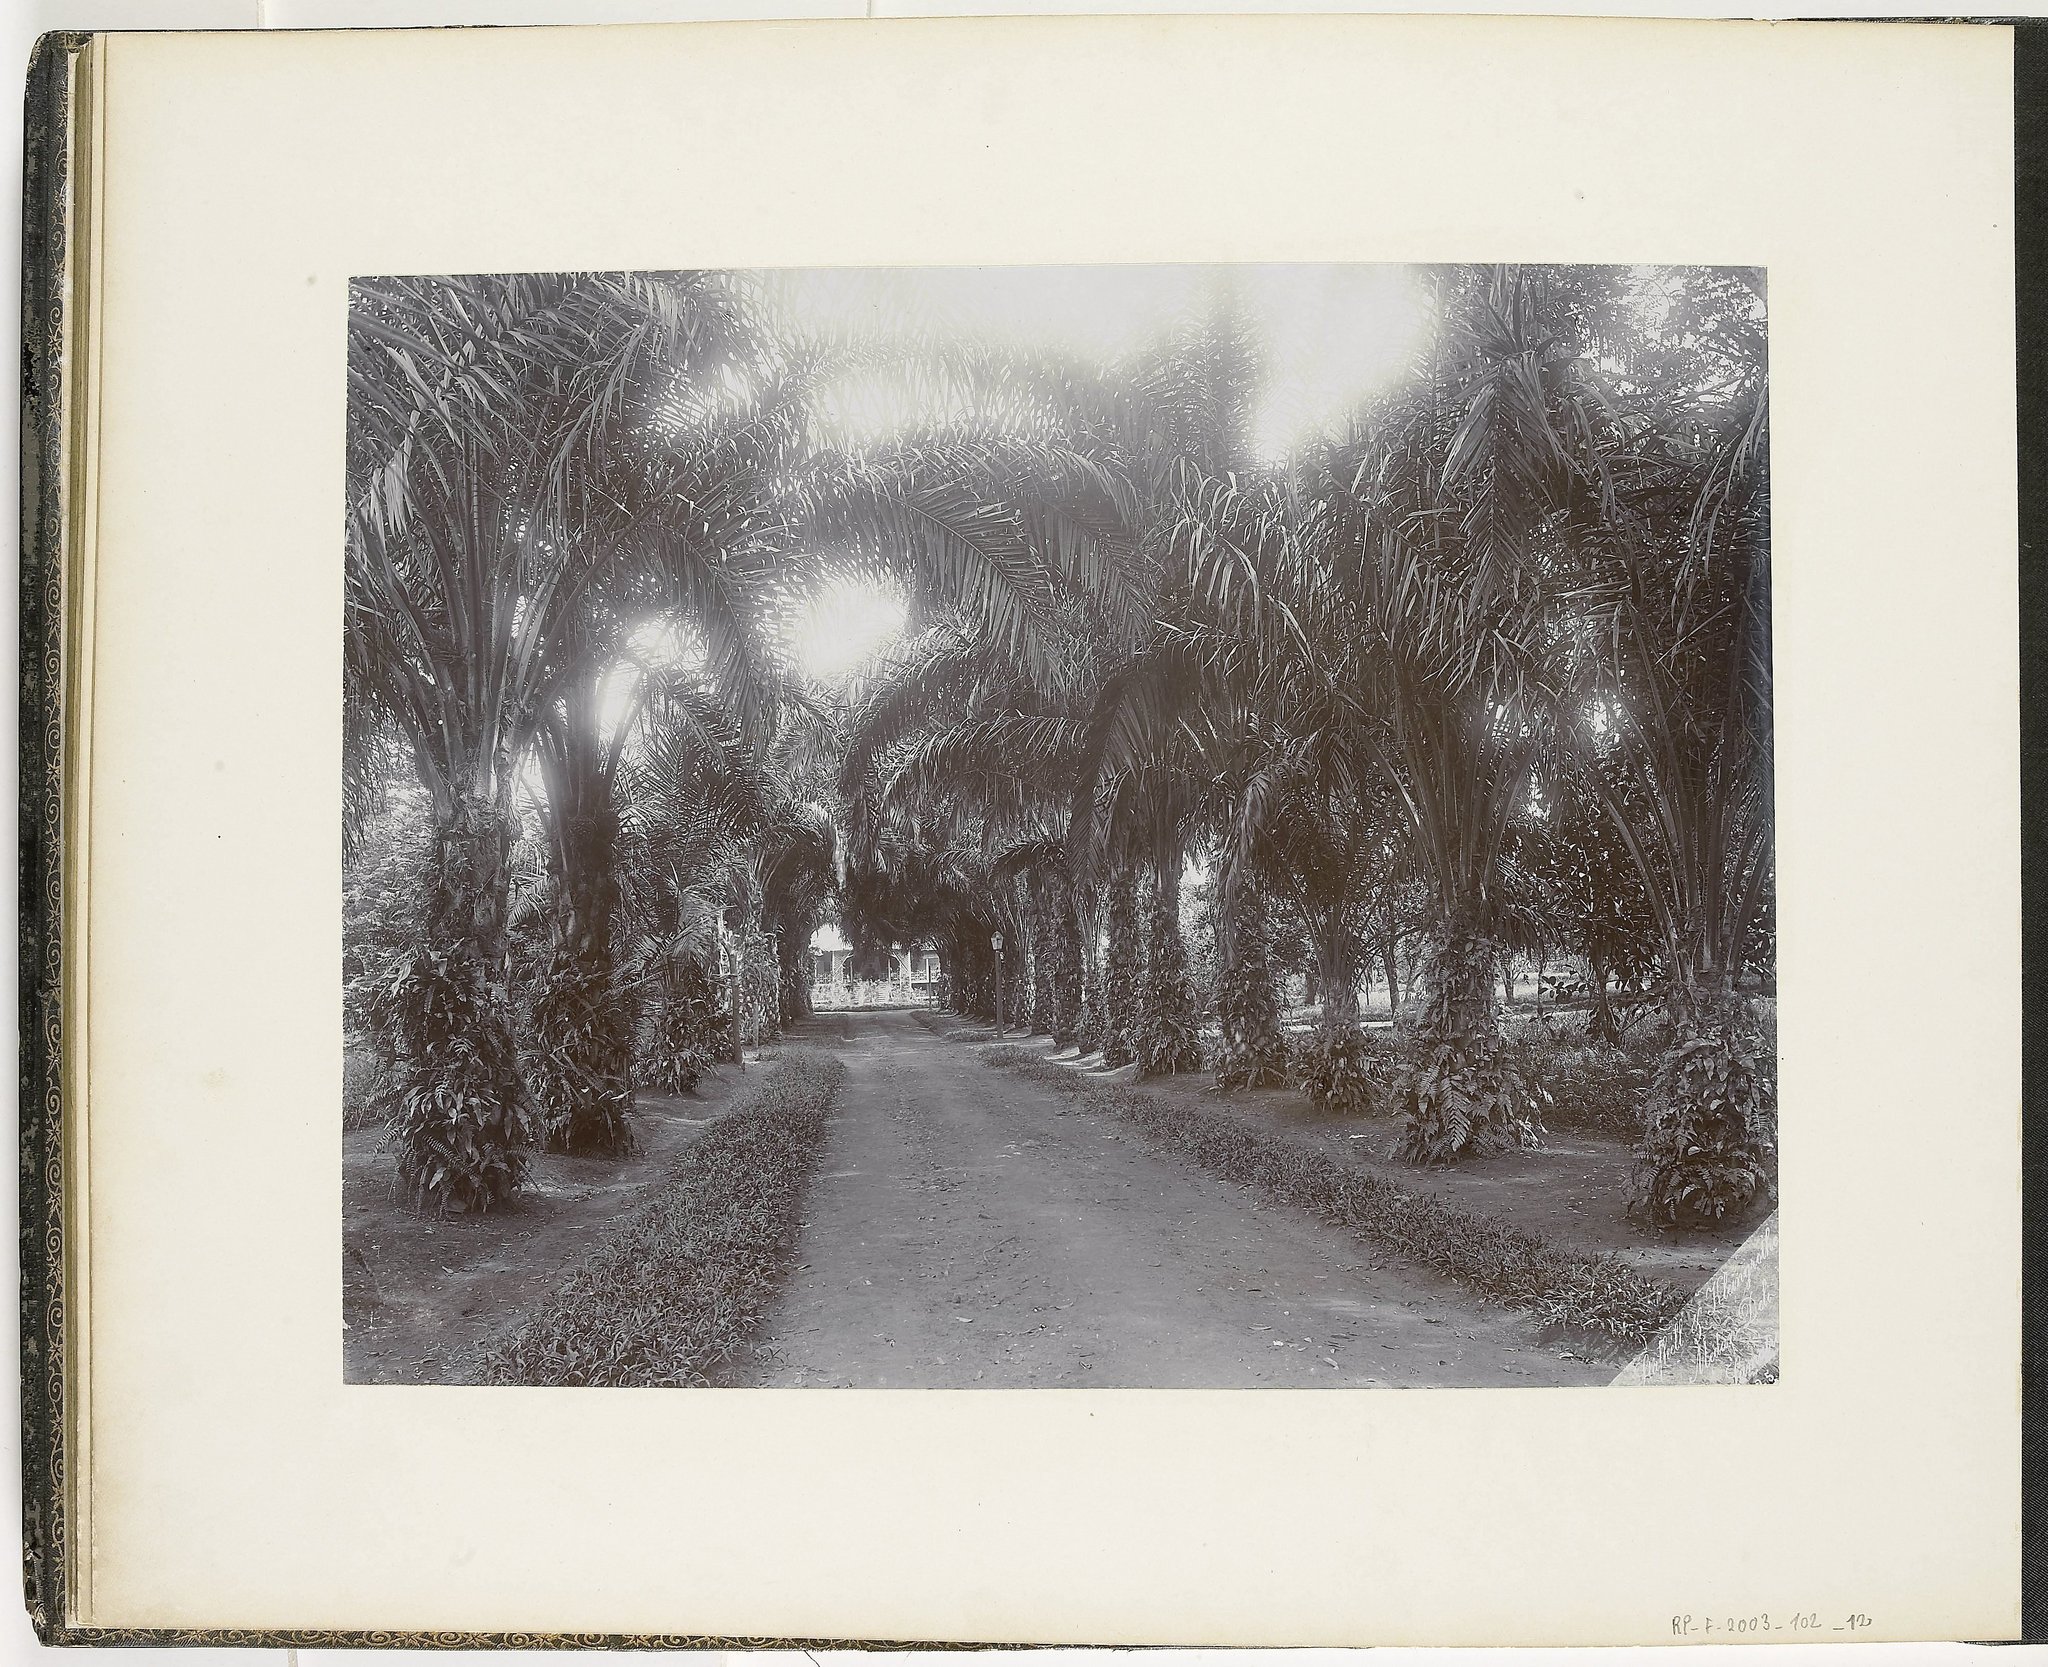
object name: photograph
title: Gezicht langs de Oliepalmen Allee St. Cyr, Sumatra (Oelpalmen Allee St. Cyr)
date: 1885-1900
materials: photographic support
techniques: collodion silver print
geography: medan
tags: sumatra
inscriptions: number: ‘Sumatra 25’, signature: ‘Stafhell & Kleingrothe Medan-Deli’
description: Gezicht in de Allee St. Cyr met aan weerszijden oliepalmen, op de plantage St. Cyr ten zuiden van Medan. Onderdeel van het Sumatra fotoalbum van Paul en Lucie Sandel uit 1900.